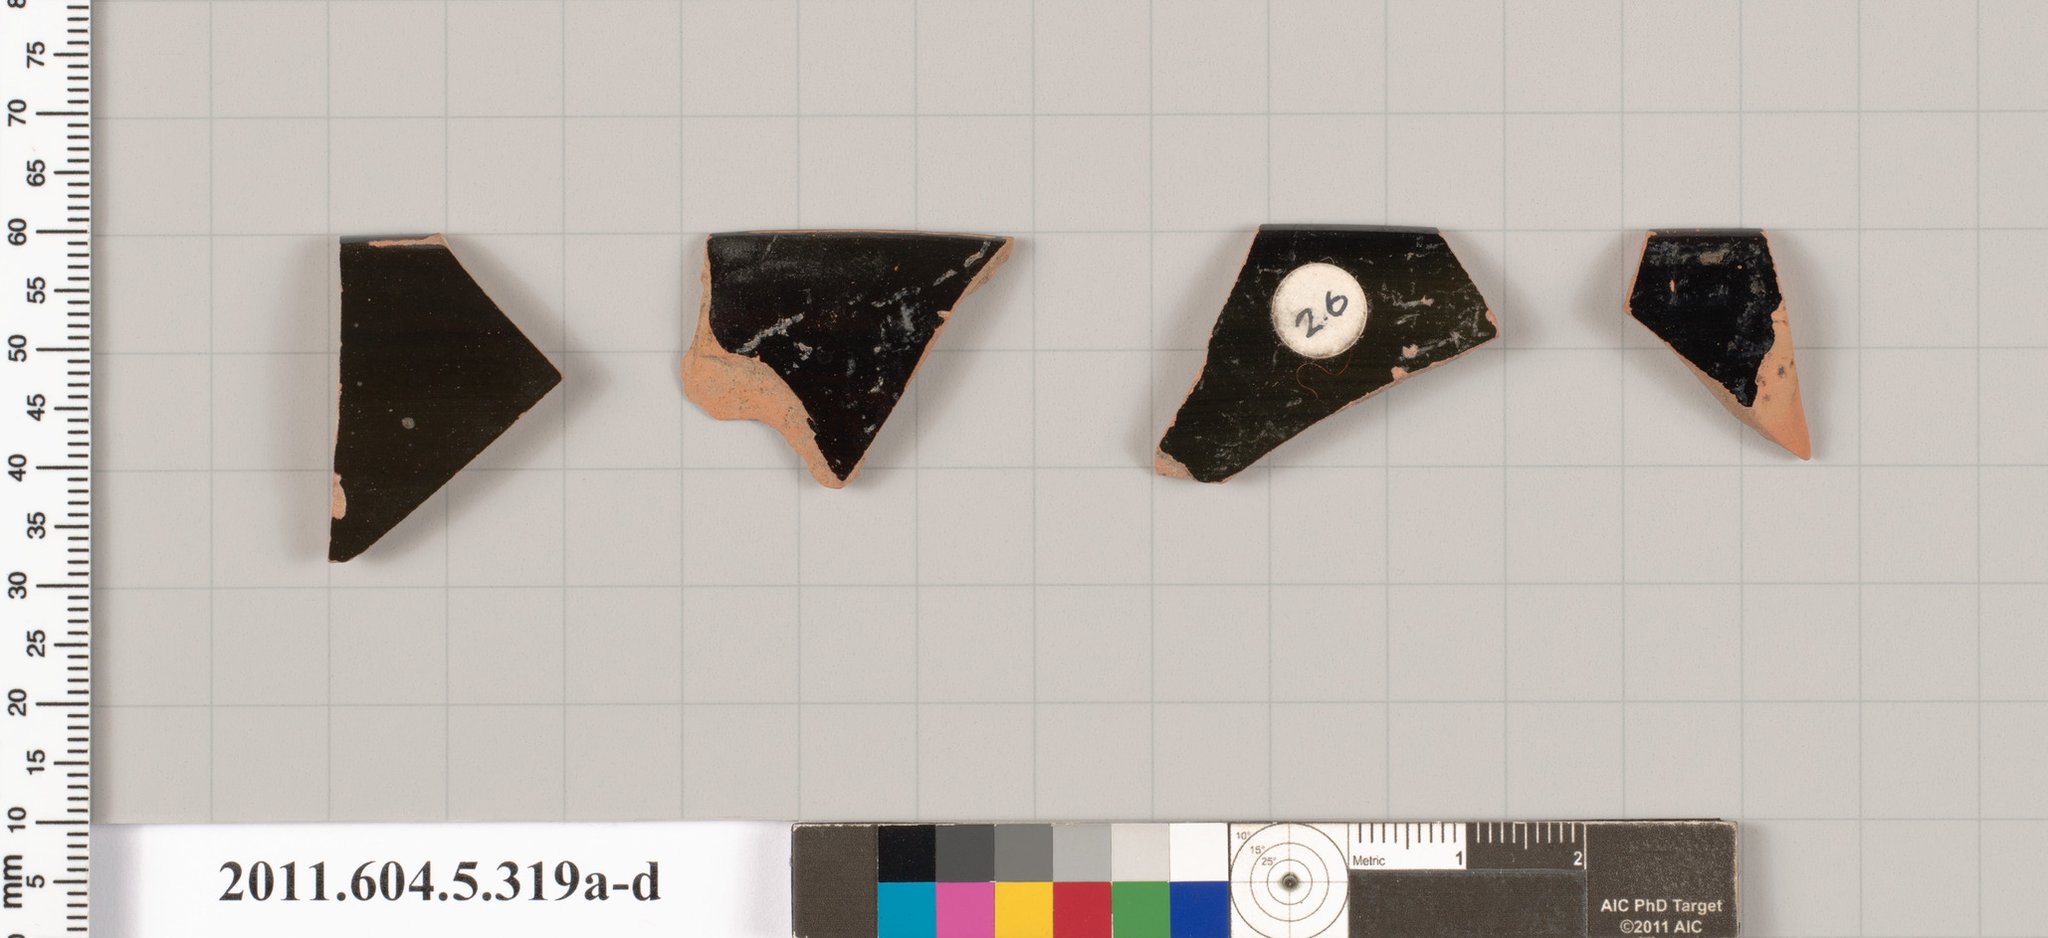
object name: kylix fragment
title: Terracotta rim fragments of kylikes (drinking cups)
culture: greek, attic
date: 600-401 BCE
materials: terracotta